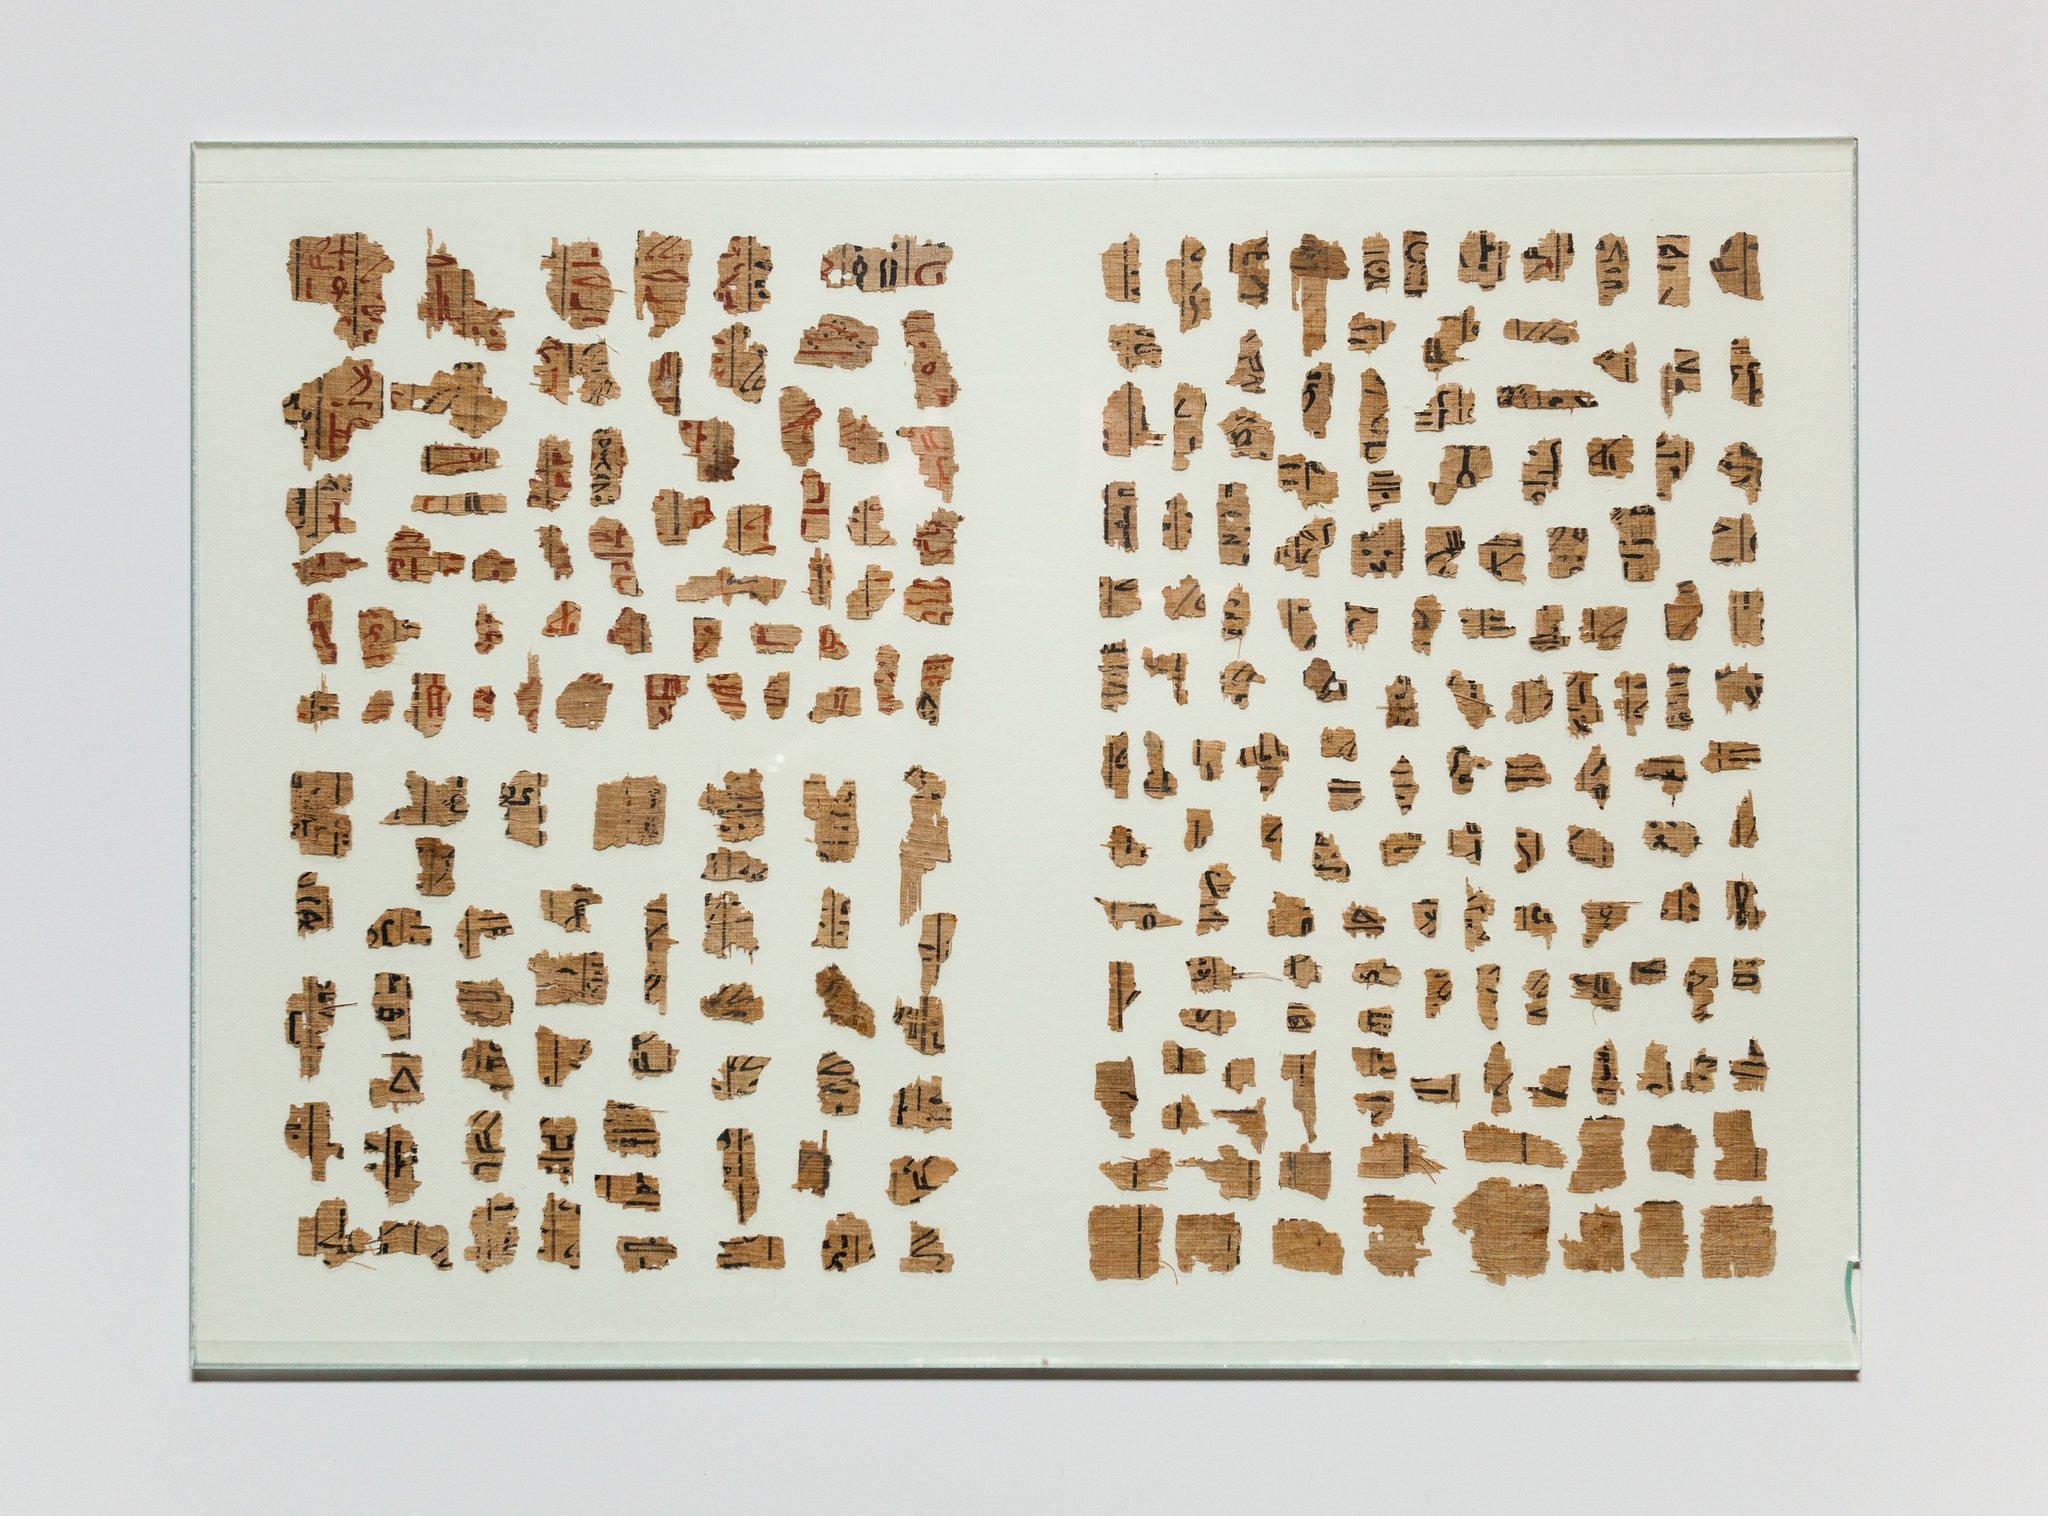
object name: papyrus, funerary, book of the dead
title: Fragments from a Book of the Dead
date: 1390-1353 BCE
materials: ink, papyrus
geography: egypt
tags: hieroglyphs